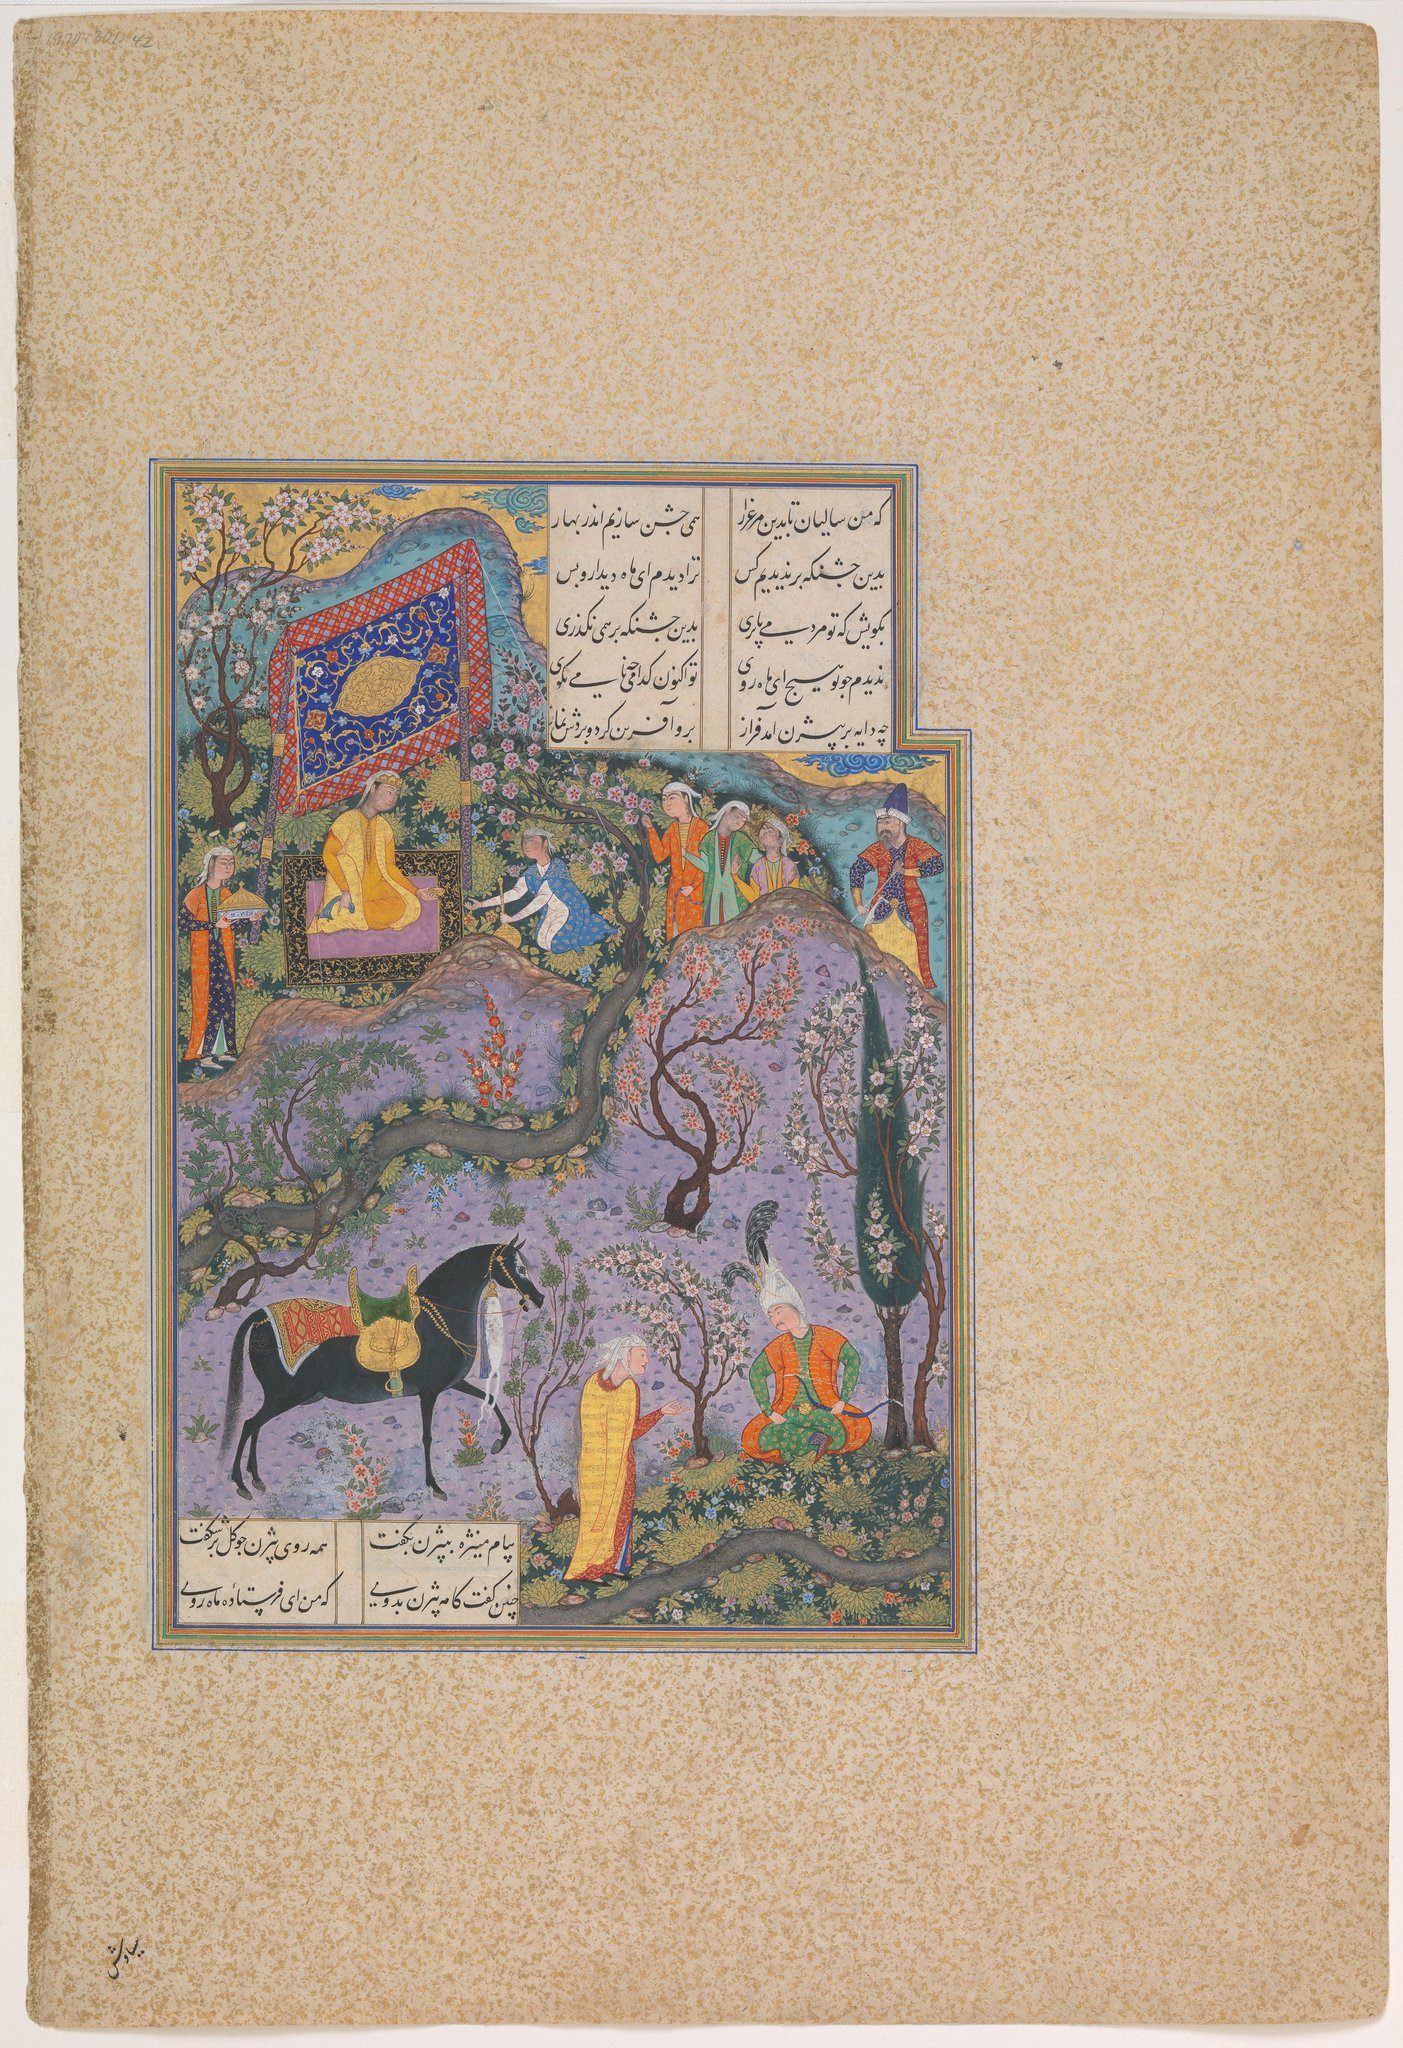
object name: folio from an illustrated manuscript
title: "Bizhan Receives an Invitation through Manizha's Nurse", Folio 300v from the Shahnama (Book of Kings) of Shah Tahmasp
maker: abu'l qasim firdausi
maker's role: author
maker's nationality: iranian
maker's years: 935-1020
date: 1525-1530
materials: gold, ink, paper, silver, watercolor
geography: iran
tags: men,women,horses